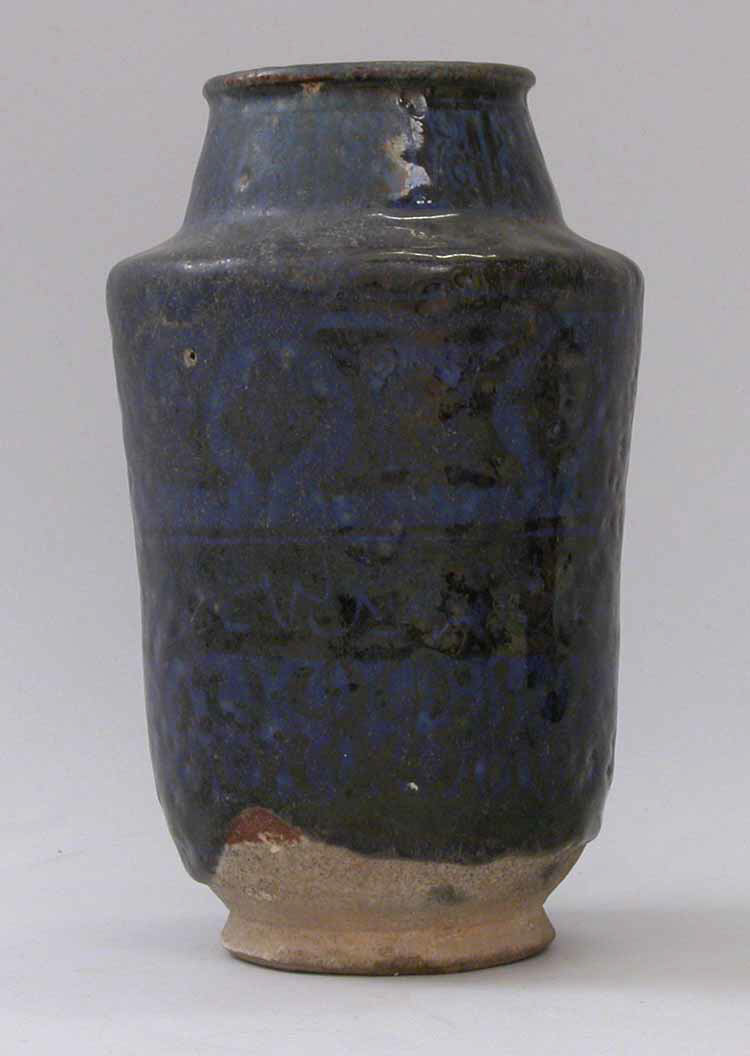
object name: jar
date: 1101-1300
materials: stonepaste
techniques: glazing, luster painting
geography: iran